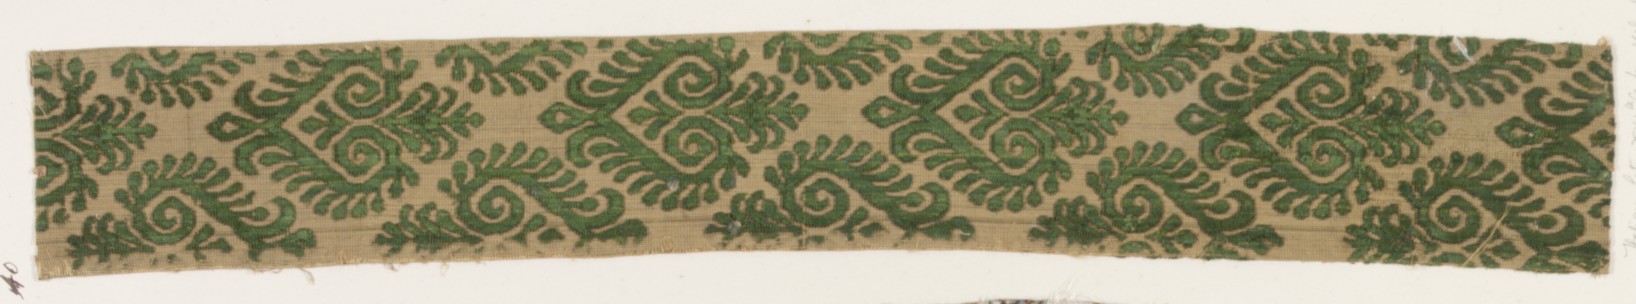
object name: fragment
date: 1501-1600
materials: silk